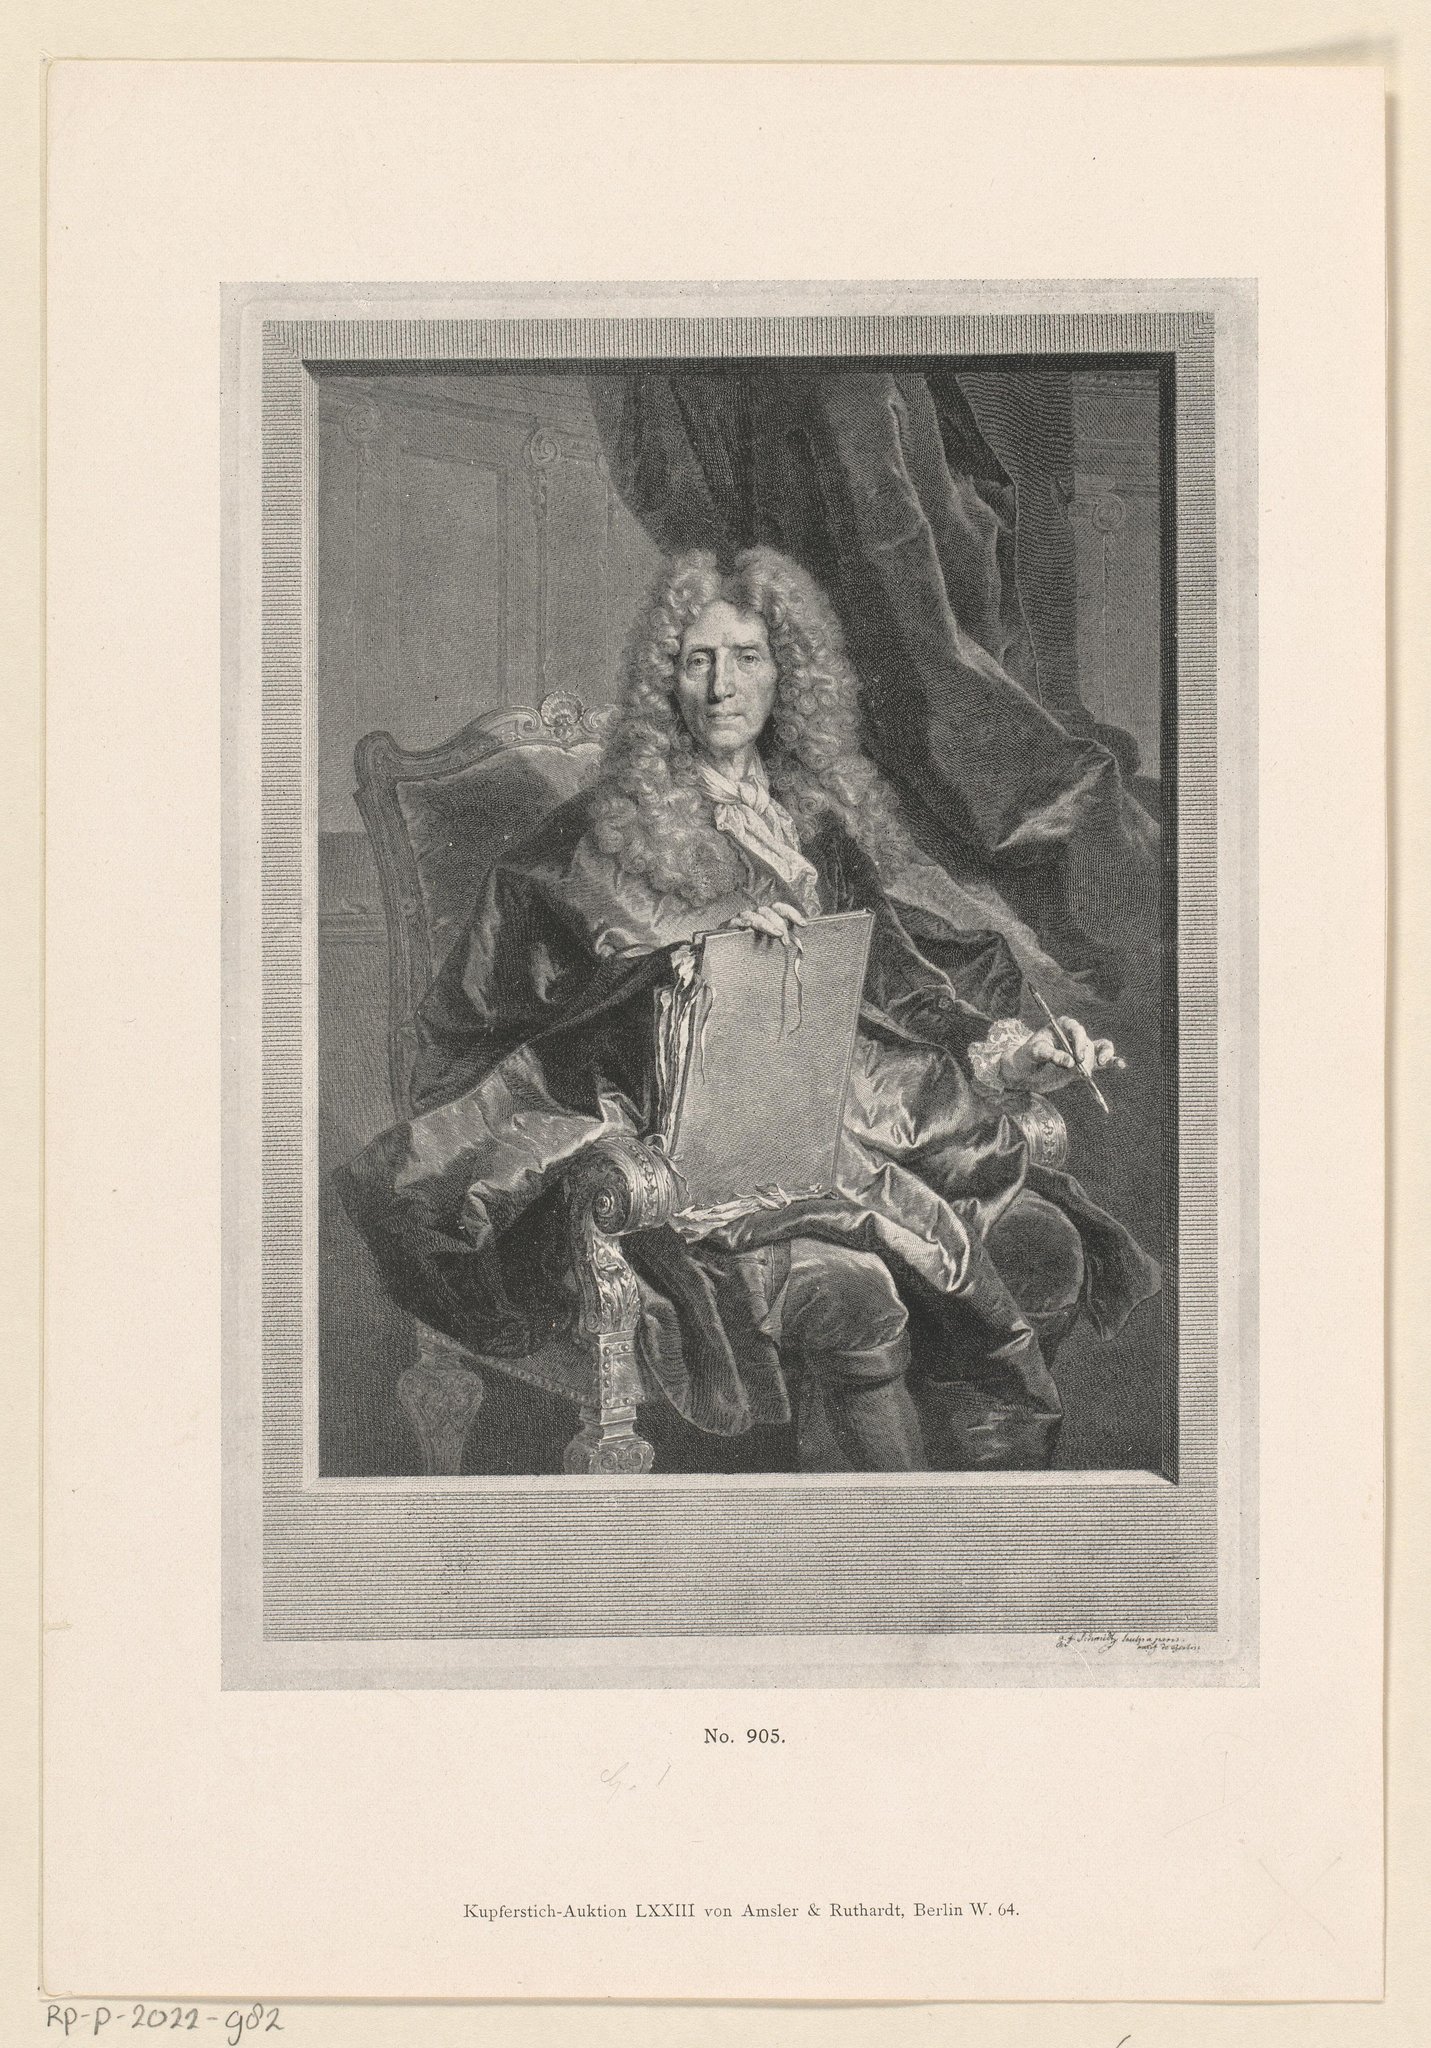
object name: photomechanical print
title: Portret van Pierre Mignard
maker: Anonymous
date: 1905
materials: paper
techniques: autotype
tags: painter, draughtsman, pierre mignard (1612-1695), historical persons, portrait, self-portrait of artist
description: Reproductie waarschijnlijk uit: Versteigerungskatalog / Amsler & Ruthardt: Katalog wertvoller und seltener Kupferstiche, (...). S.l.s.n., 1905.